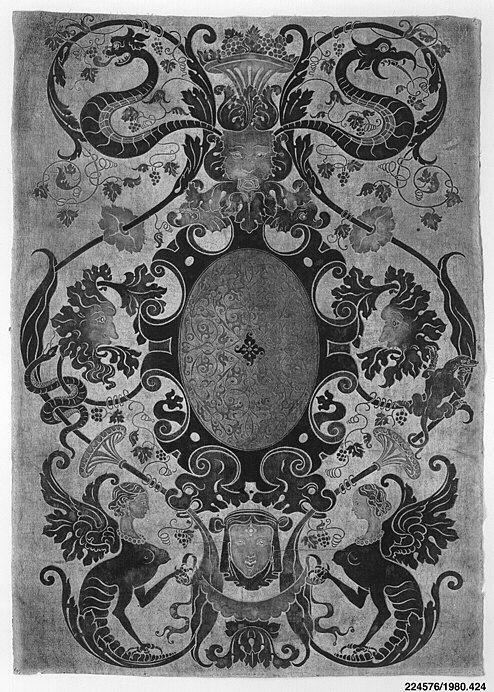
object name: panel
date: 1801-1900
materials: cotton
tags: masks,dragons